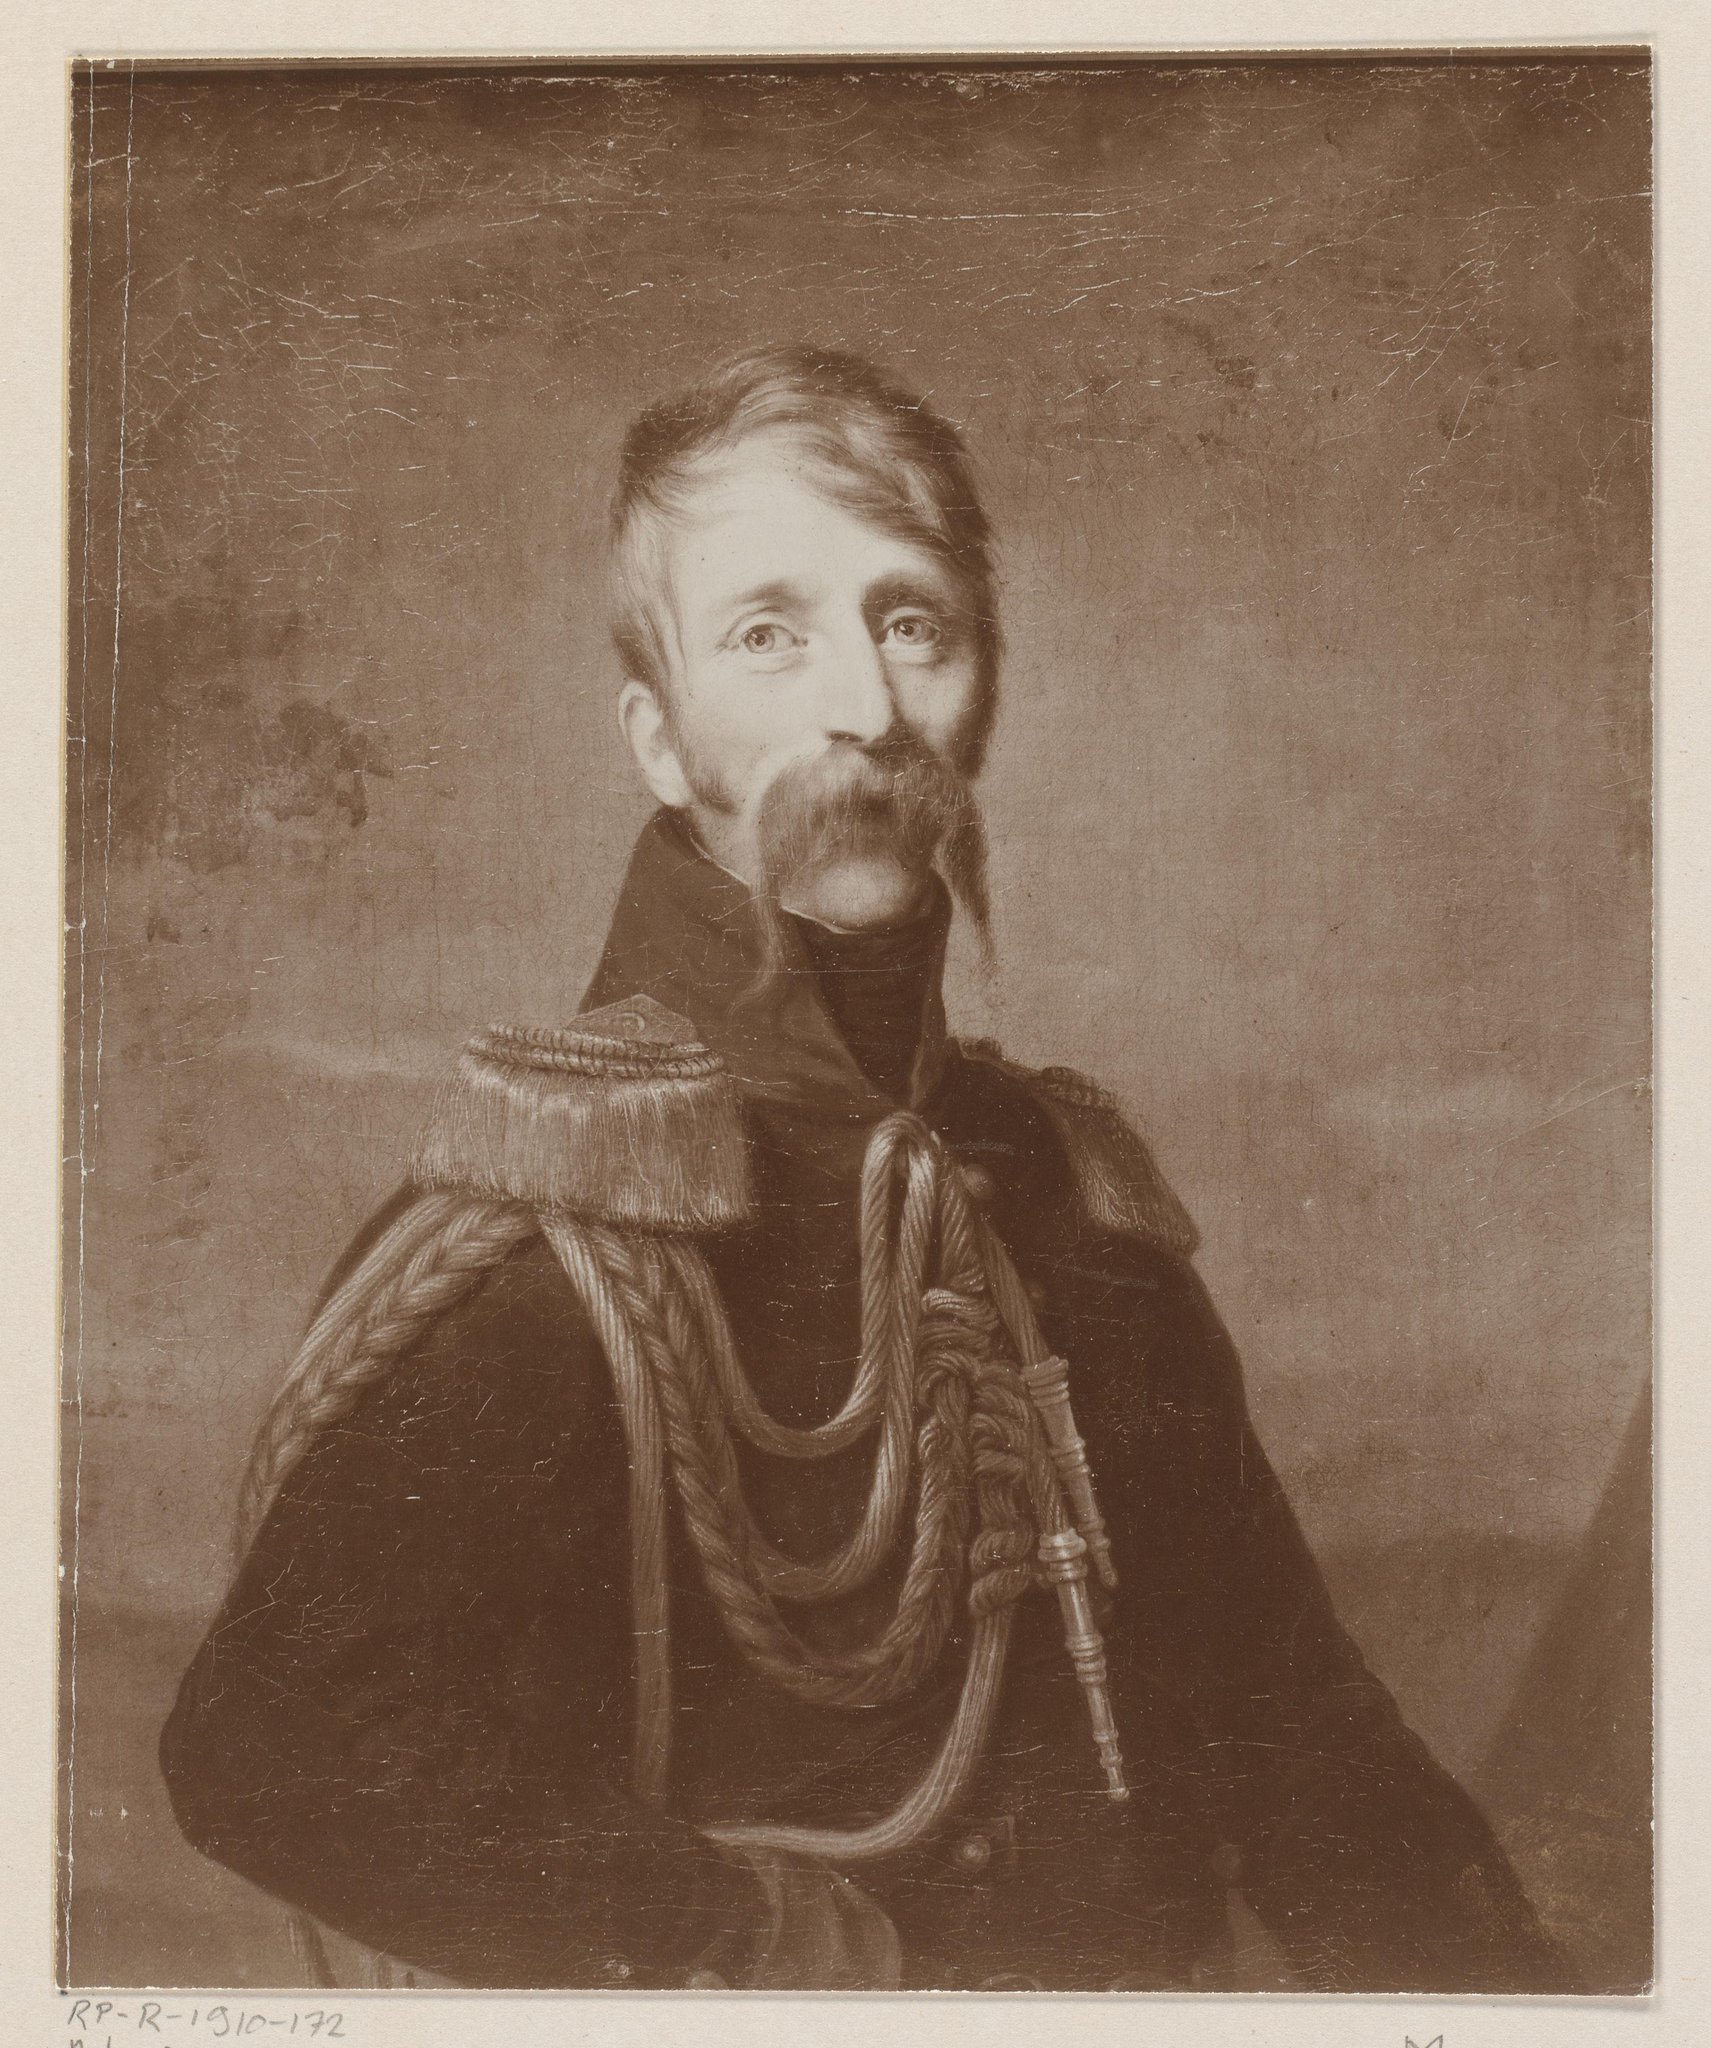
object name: photograph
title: Fotoreproductie van een geschilderd portret van Jan Post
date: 1880-1910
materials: paper, cardboard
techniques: collodion silver print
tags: historical persons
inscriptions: collector's mark: Lugt 2228